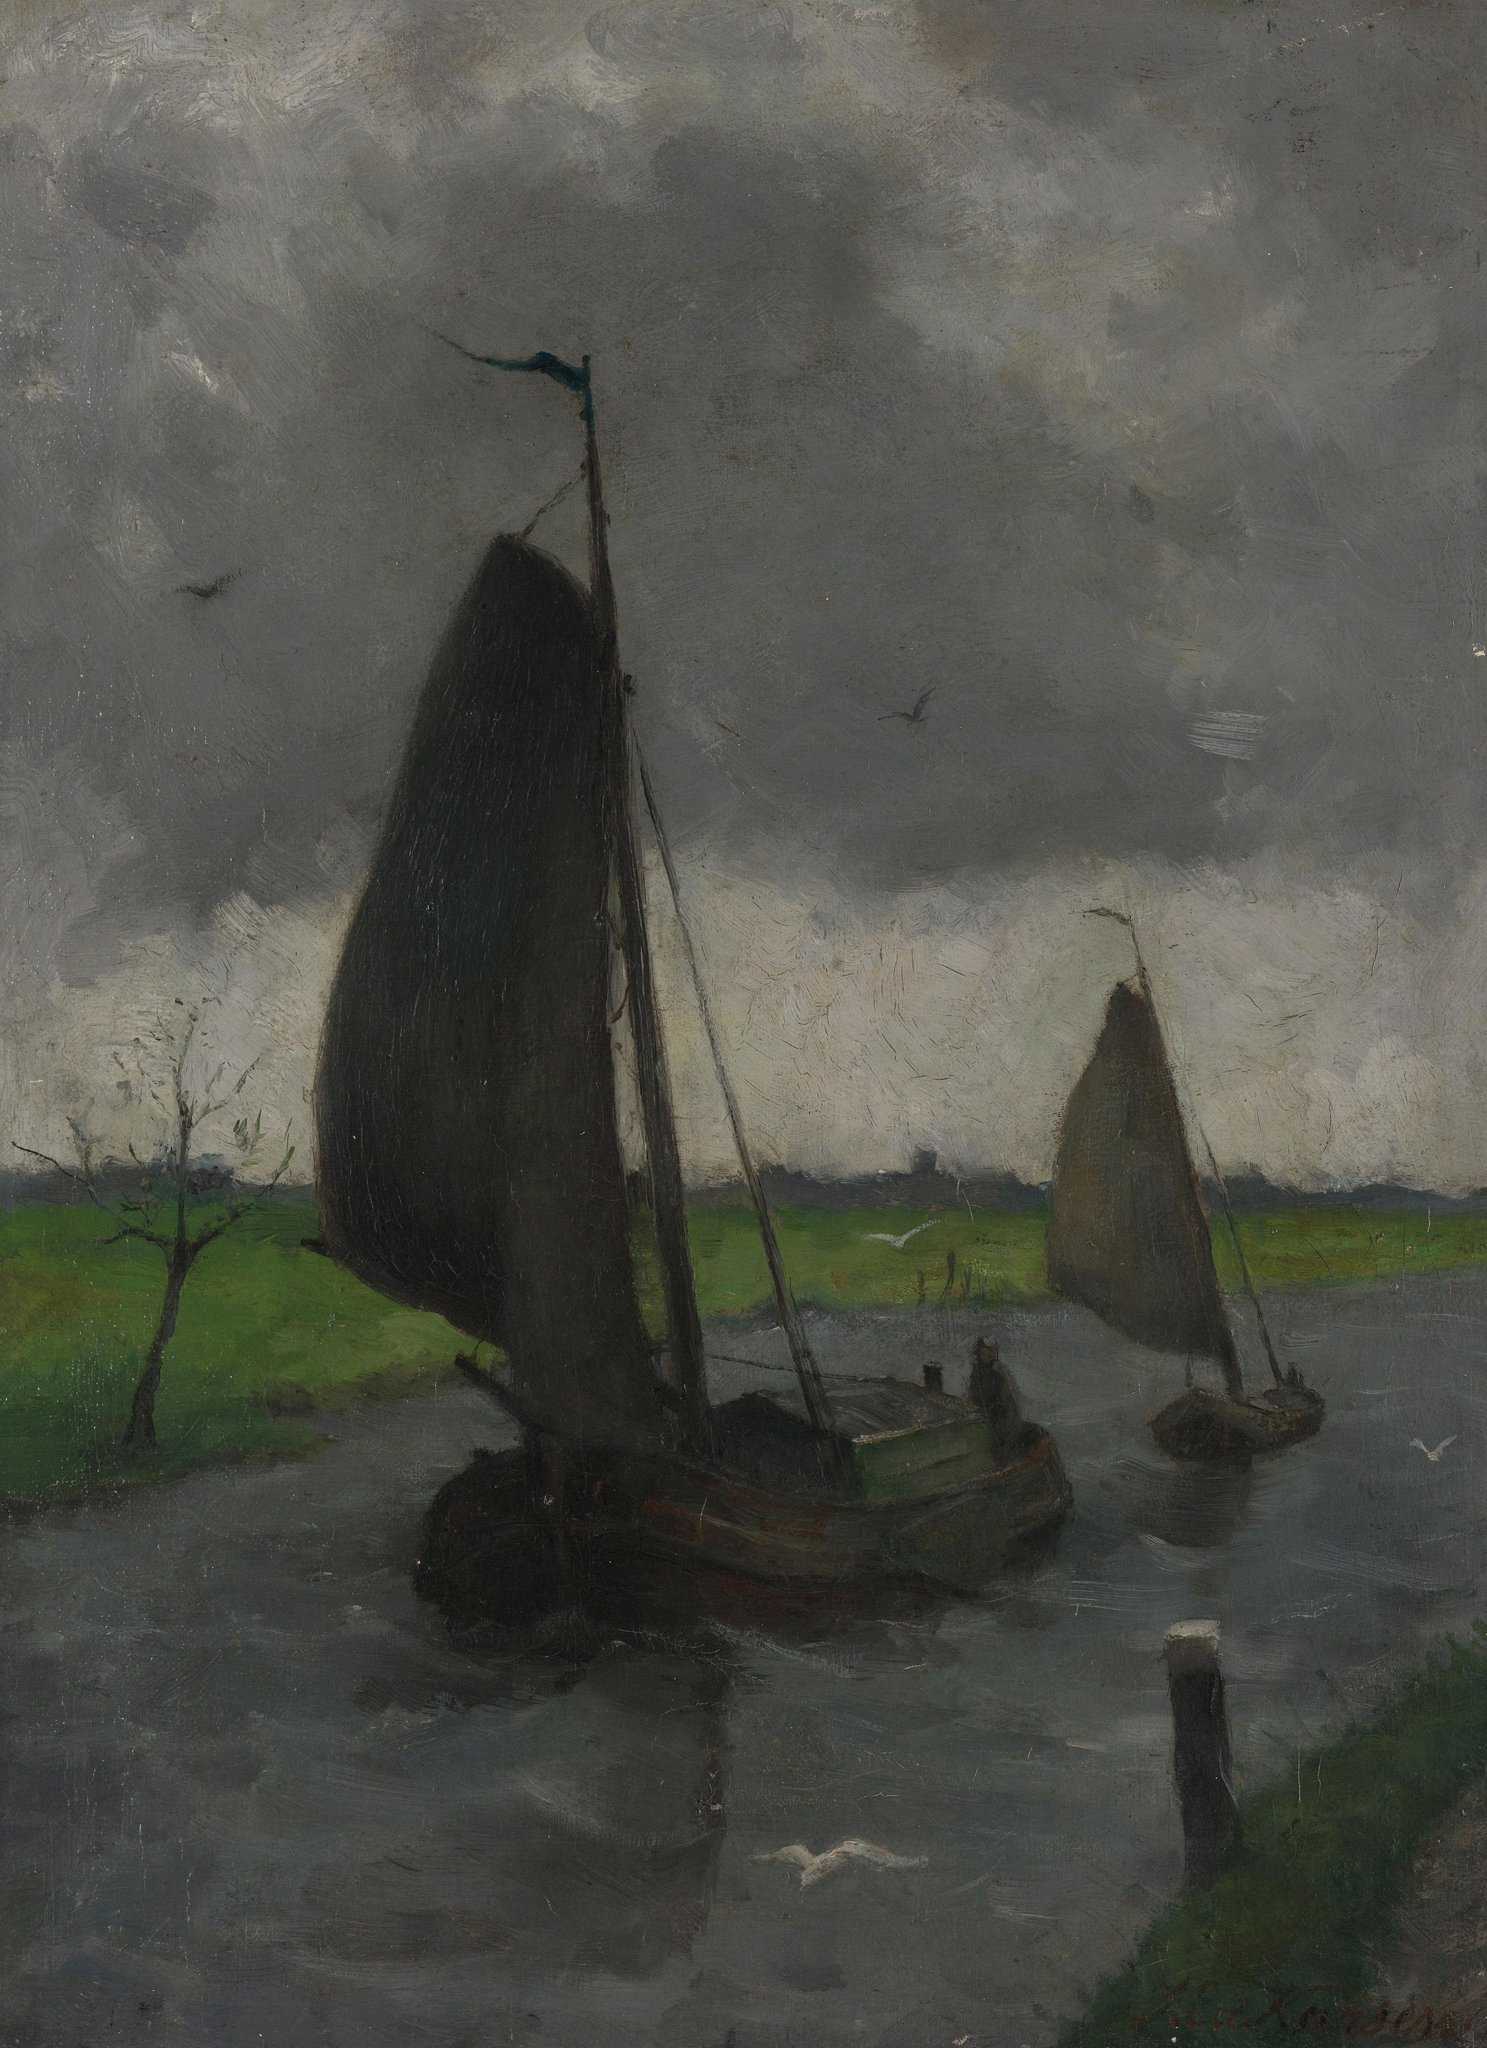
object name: painting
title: Watercourse with Sail Barges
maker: eduard karsen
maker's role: draughtsman, painter, print maker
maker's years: 1860-1941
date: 1885-1912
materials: canvas, oil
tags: sailing-ship, sailing-boat, water course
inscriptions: signature: ‘Ed. Karsen’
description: Een vaart met twee zeilende schuiten. In de lucht enkele meeuwen.